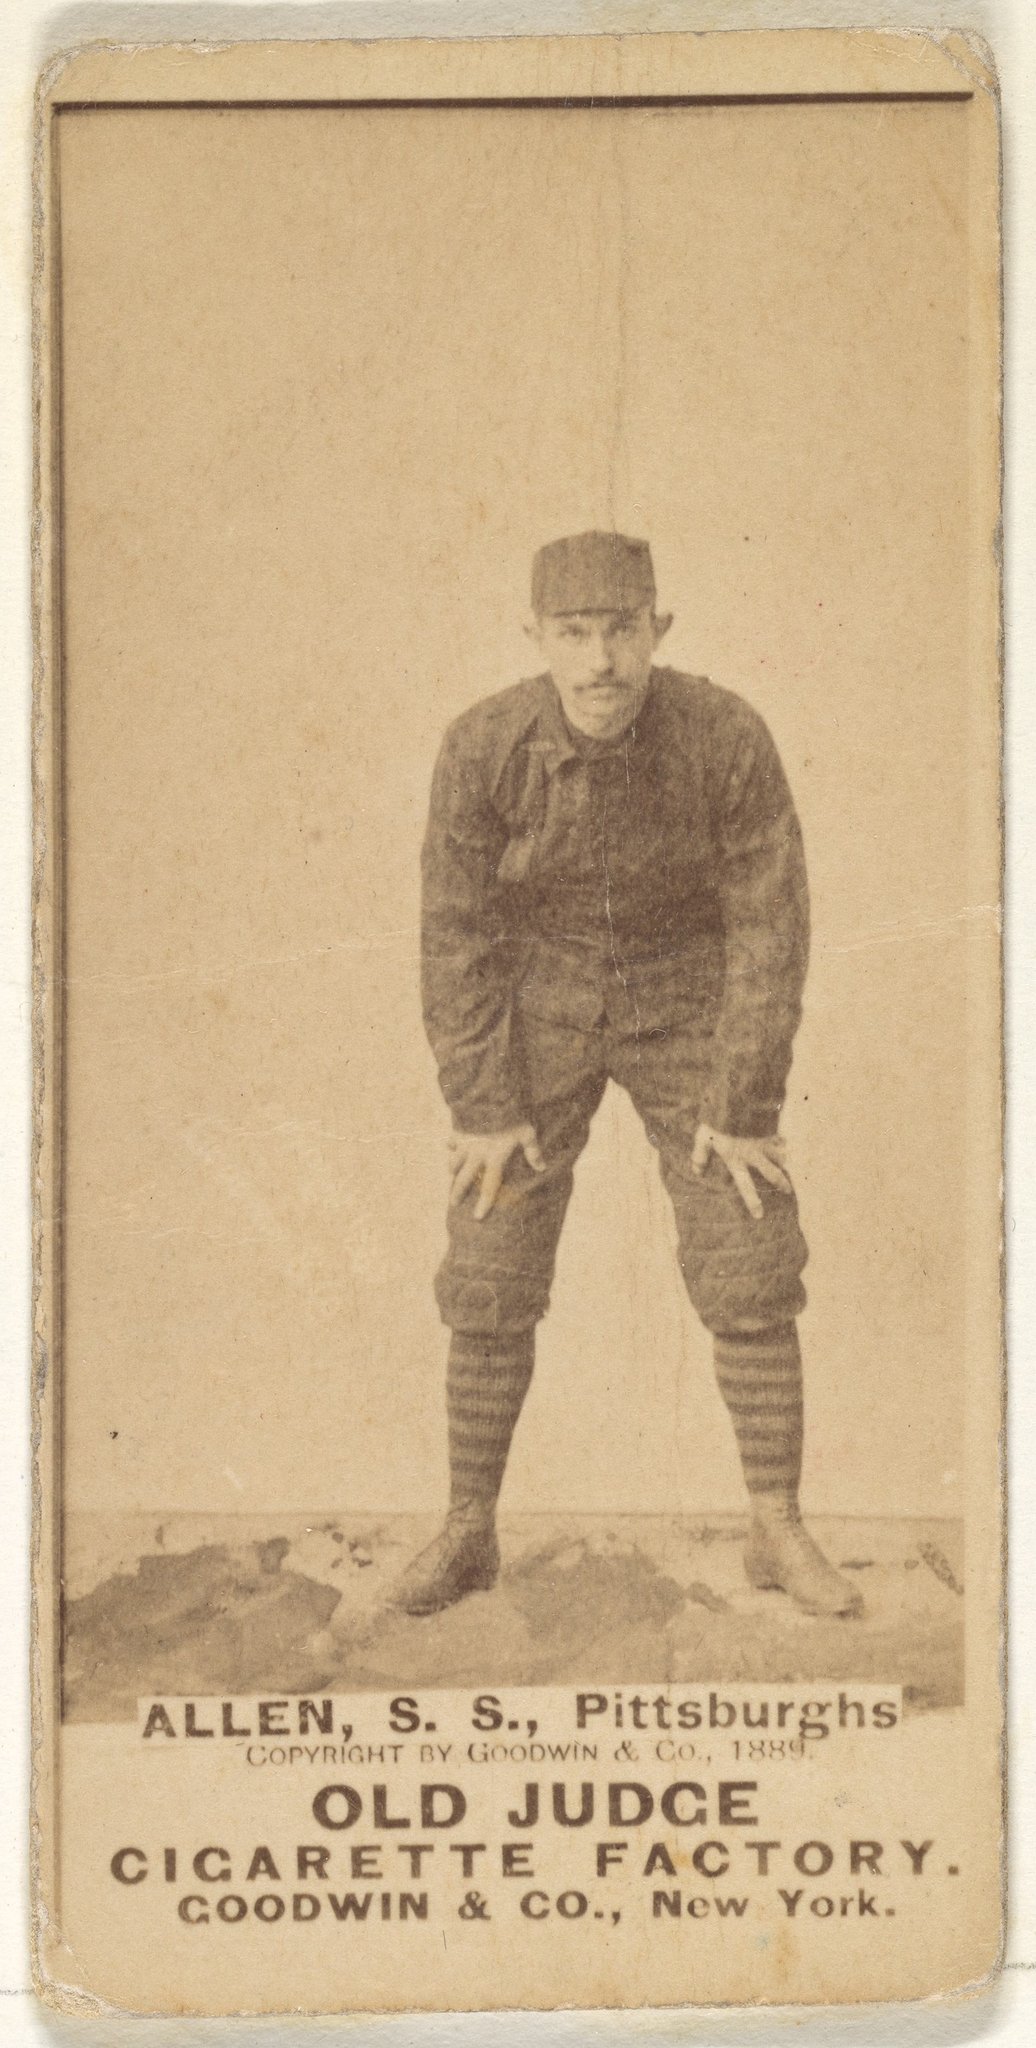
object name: baseball card, photograph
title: Allen, Shortstop, Pittsburgh, from the Old Judge series (N172) for Old Judge Cigarettes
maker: goodwin & company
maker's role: publisher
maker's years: 1850-1950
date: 1889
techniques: albumen silver print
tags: men,baseball,athletes